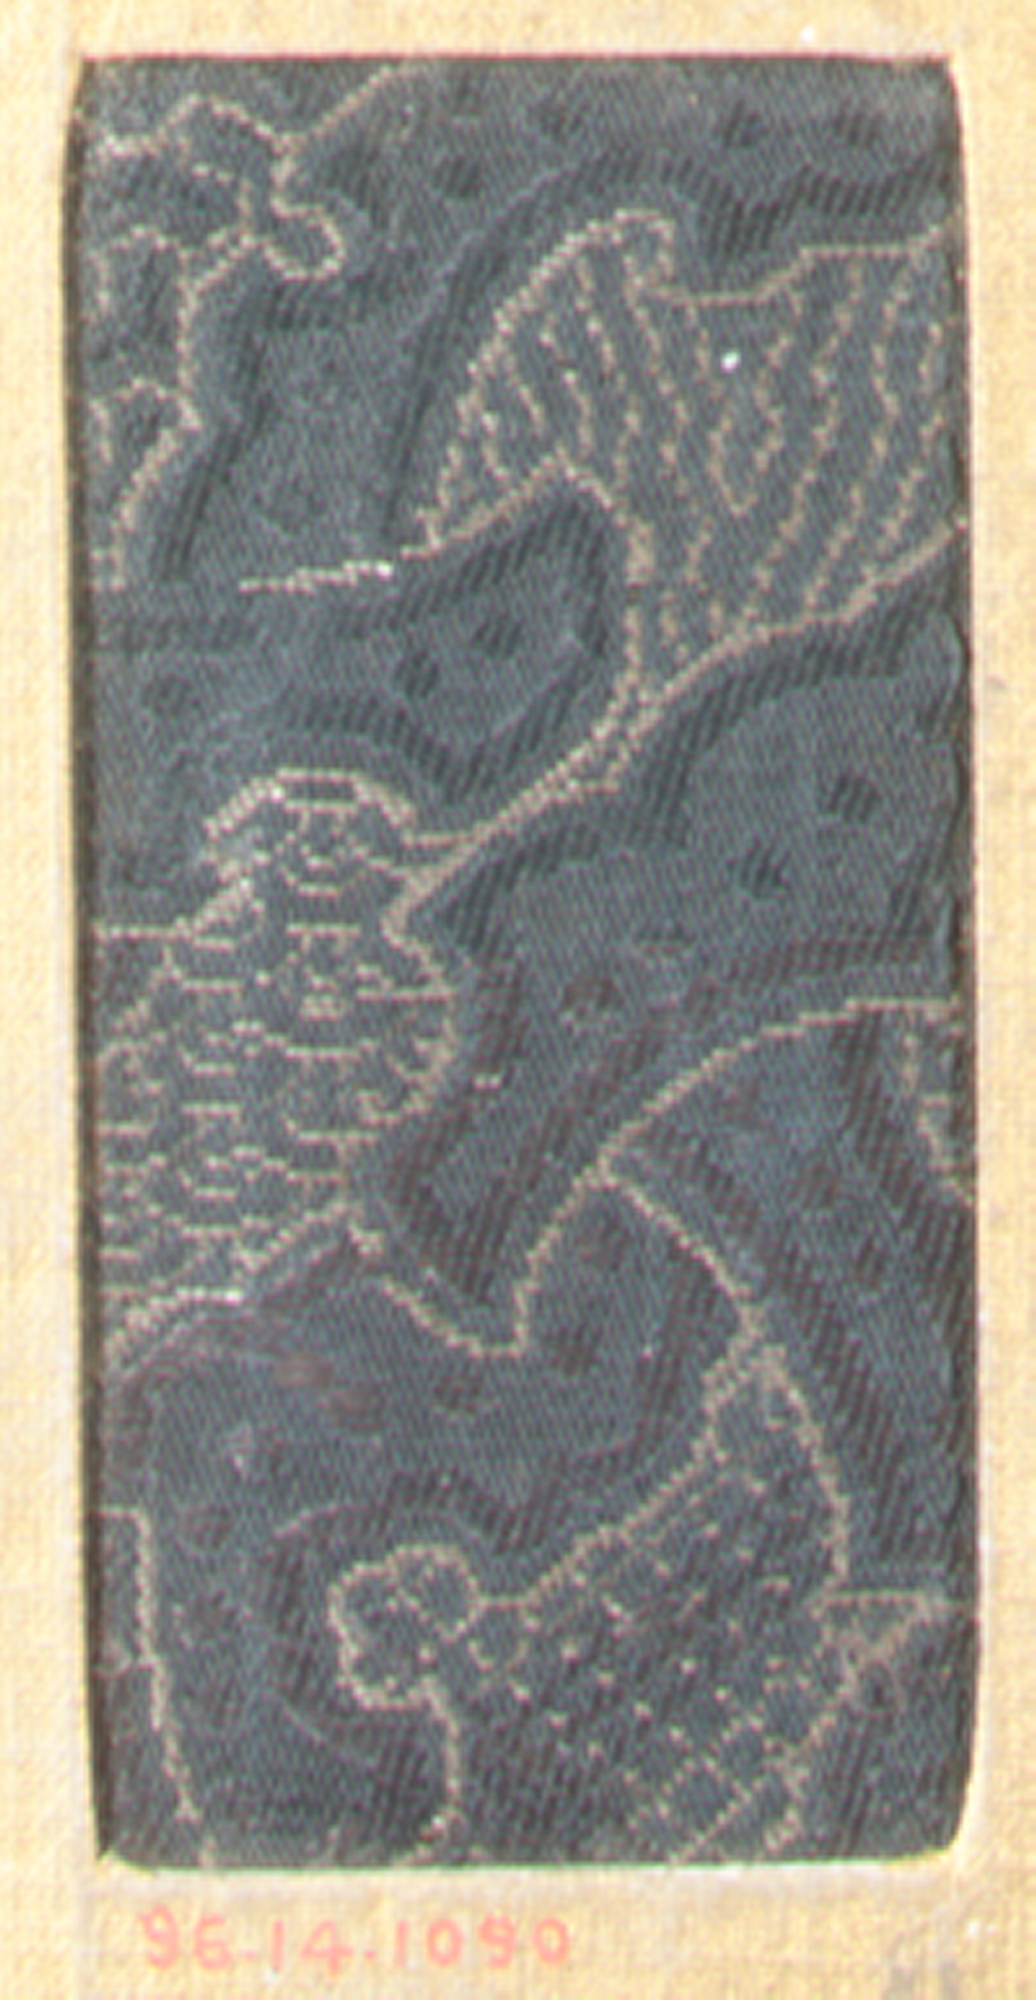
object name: piece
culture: japanese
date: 1701-1900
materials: silk